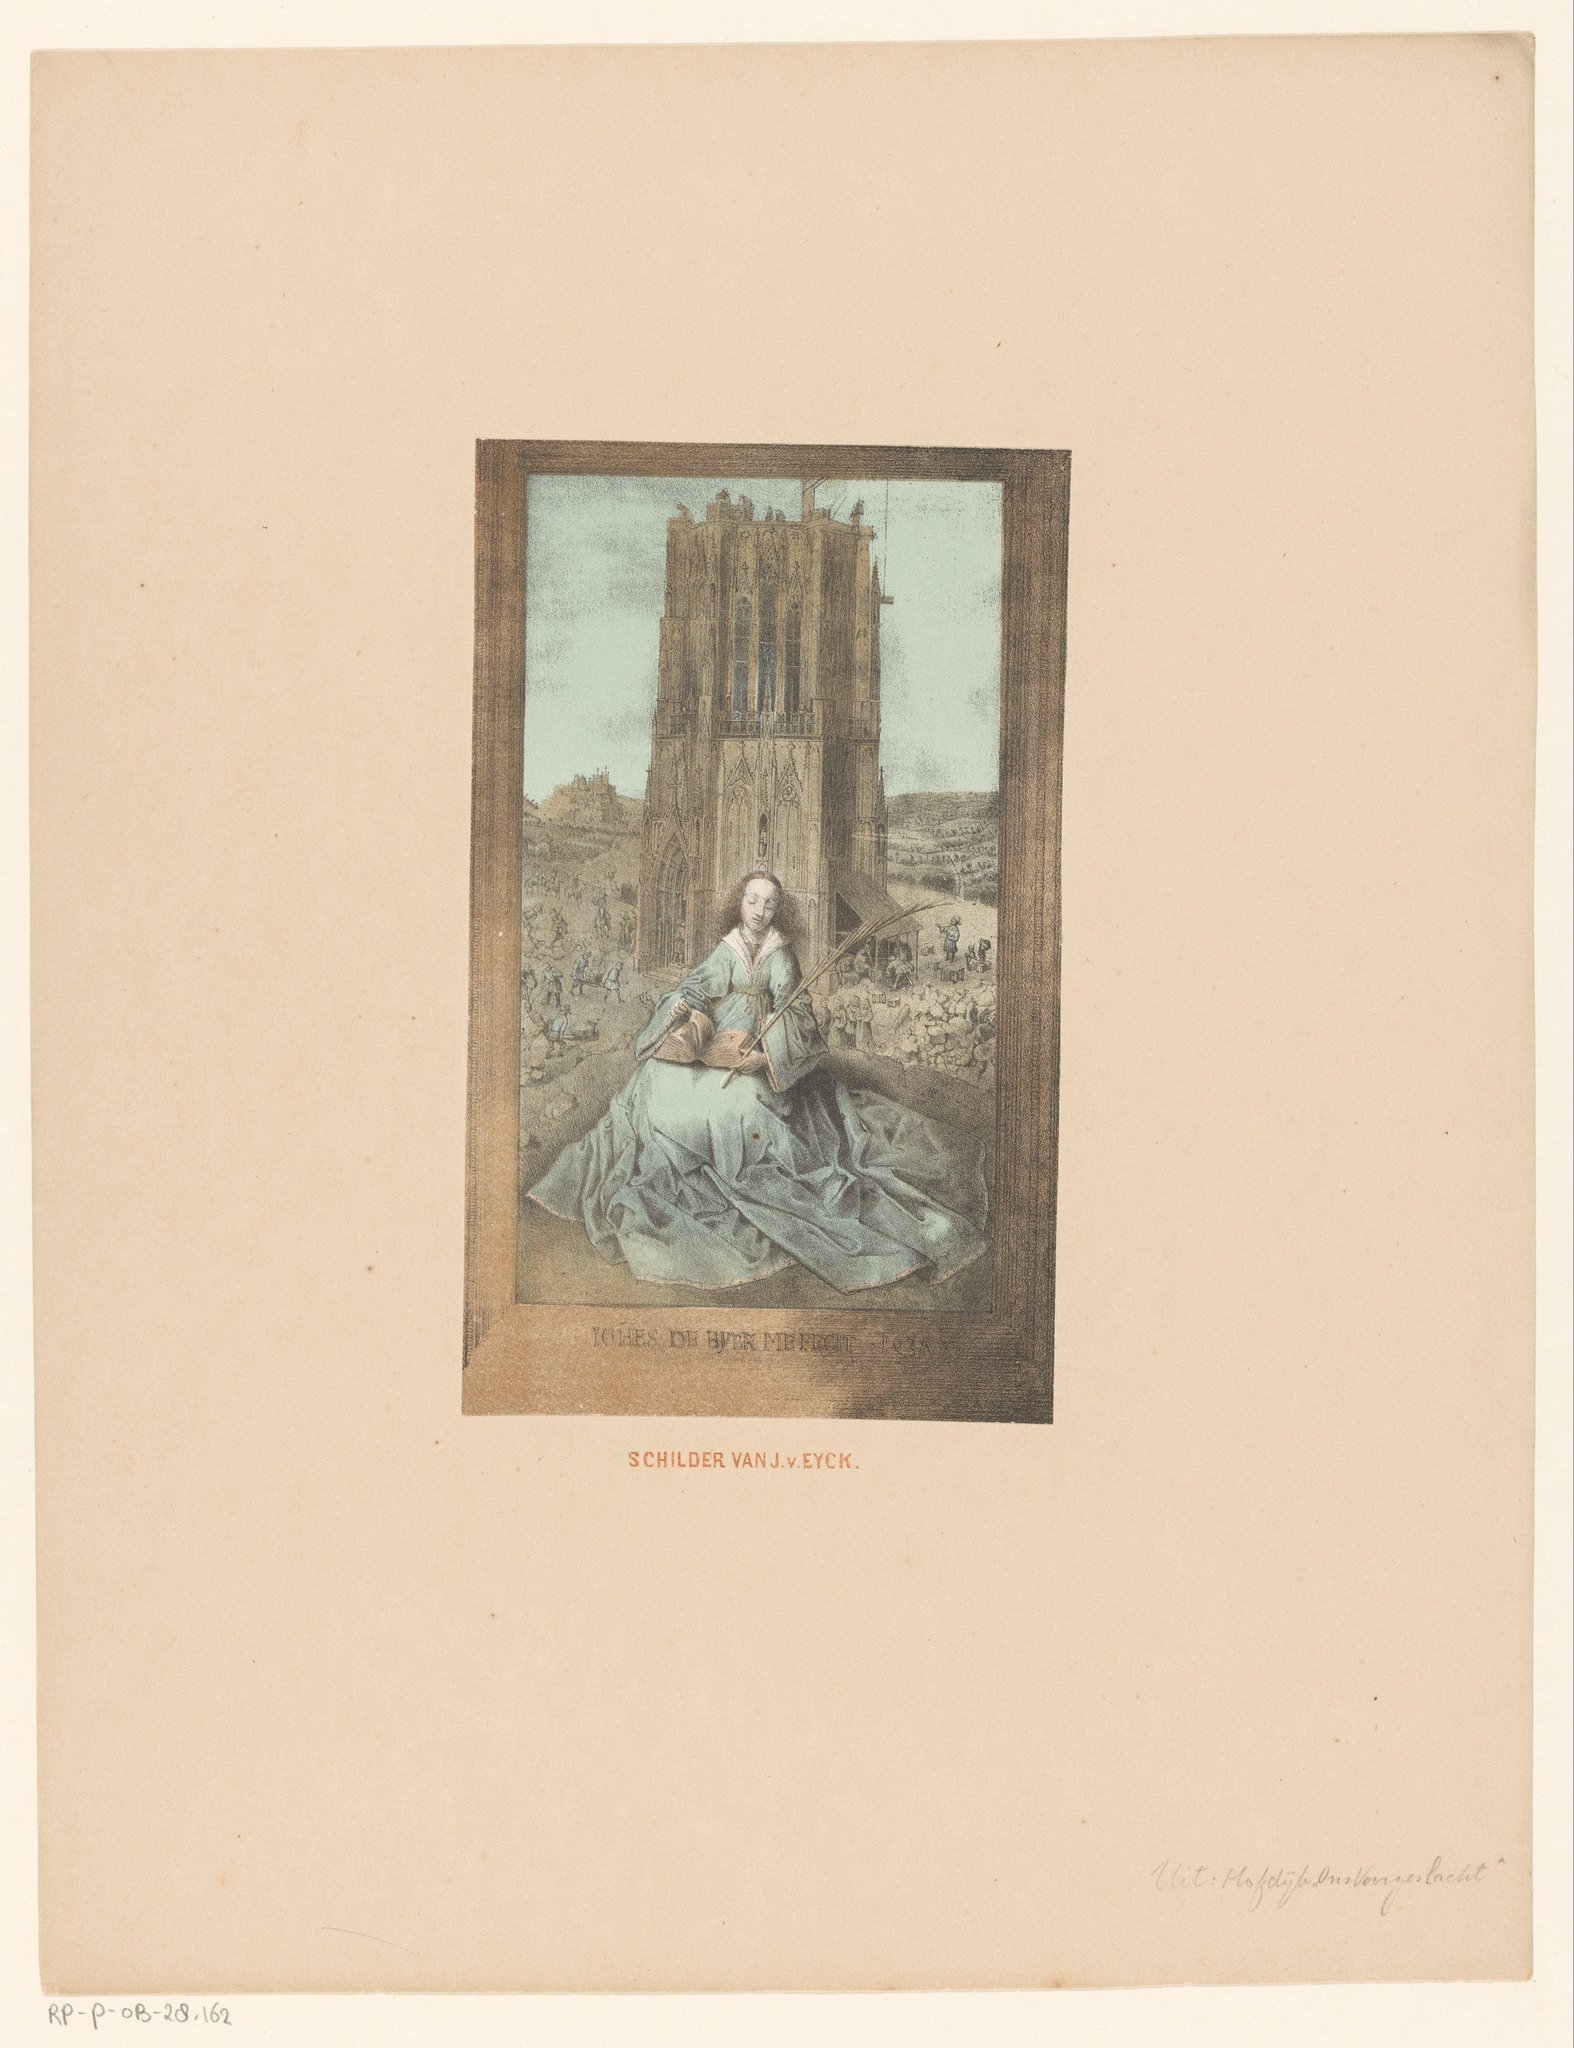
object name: print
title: Heilige Barbara van Nicodemië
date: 1857-1864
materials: paper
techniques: lithograph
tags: the virgin martyr barbara; possible attributes: book, cannon(ball), crown, cross, chalice with wafer, dioscuros (her father), peacock feather, sword, torches, mason's tools, tower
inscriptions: collector's mark: Lugt 2228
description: De heilige Barbara zit voor de toren waarin zij door haar vader werd opgesloten. In haar handen heeft zij een boek en een palmtak.